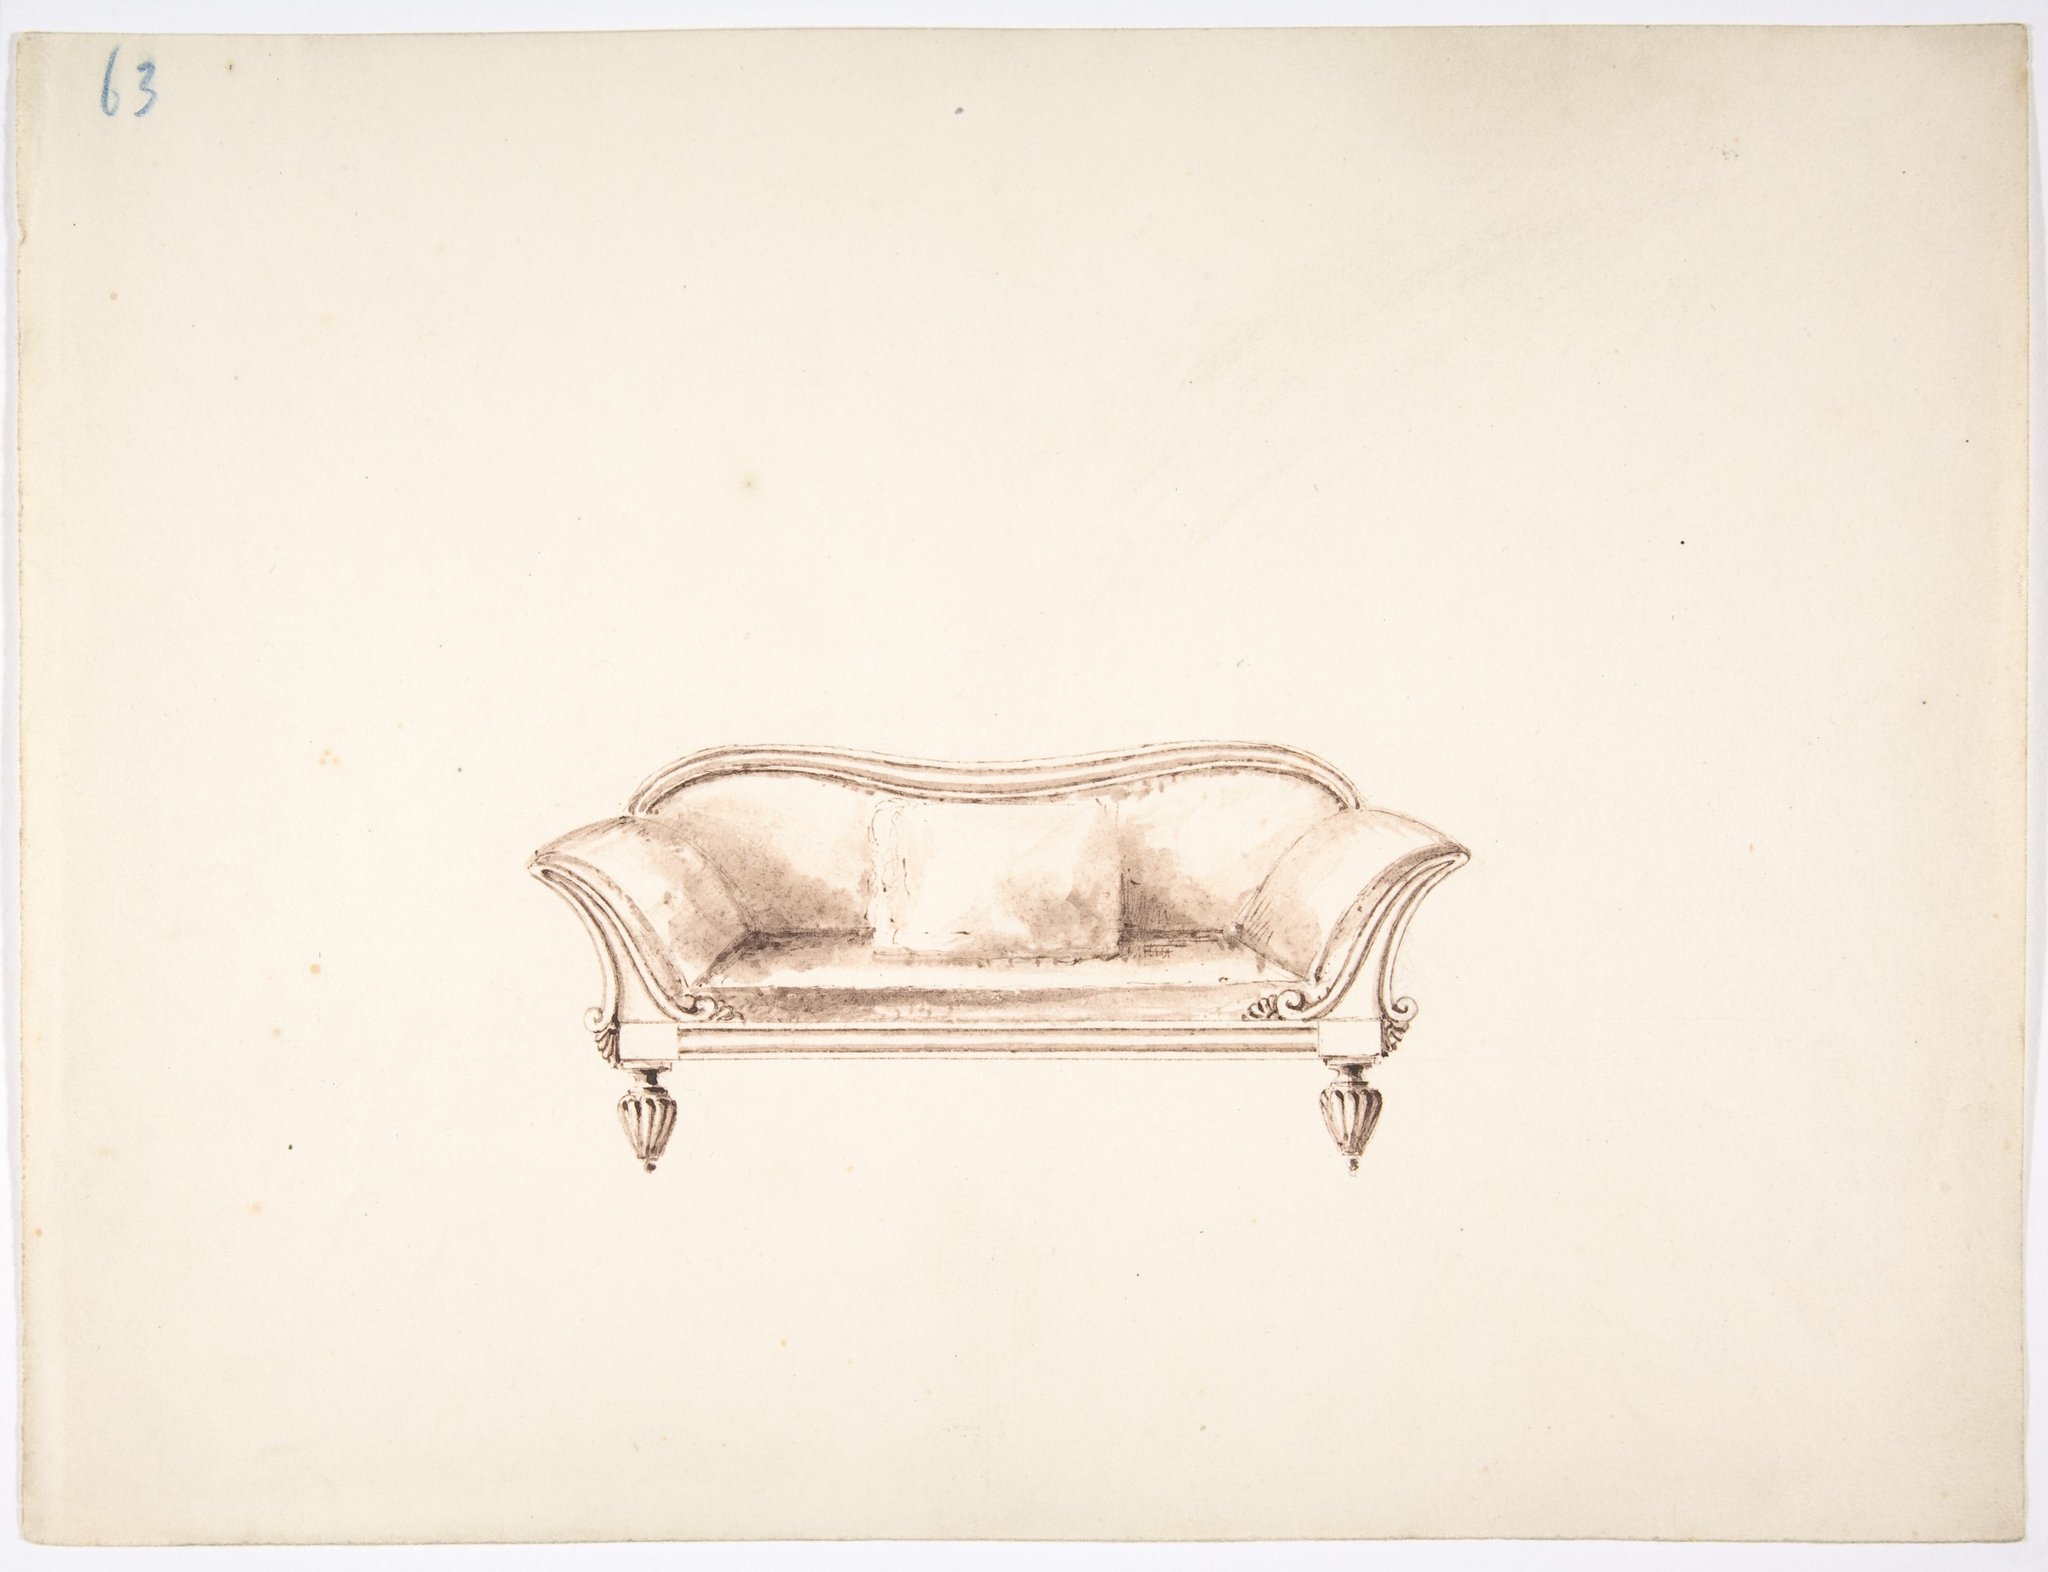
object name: drawing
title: Design for a Sofa with Wing-like Arms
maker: anonymous, british, 19th century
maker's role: artist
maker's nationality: british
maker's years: 1800-1900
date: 1801-1833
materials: ink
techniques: brush, pen, wash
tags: couches